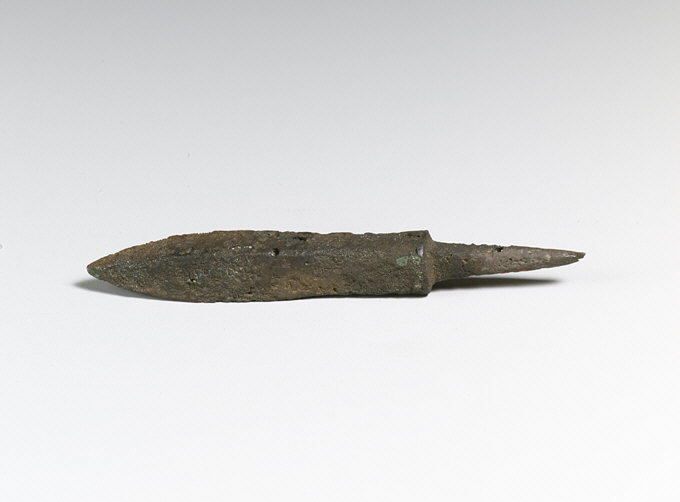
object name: arrowhead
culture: greek, cypriot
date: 480-330 BCE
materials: bronze